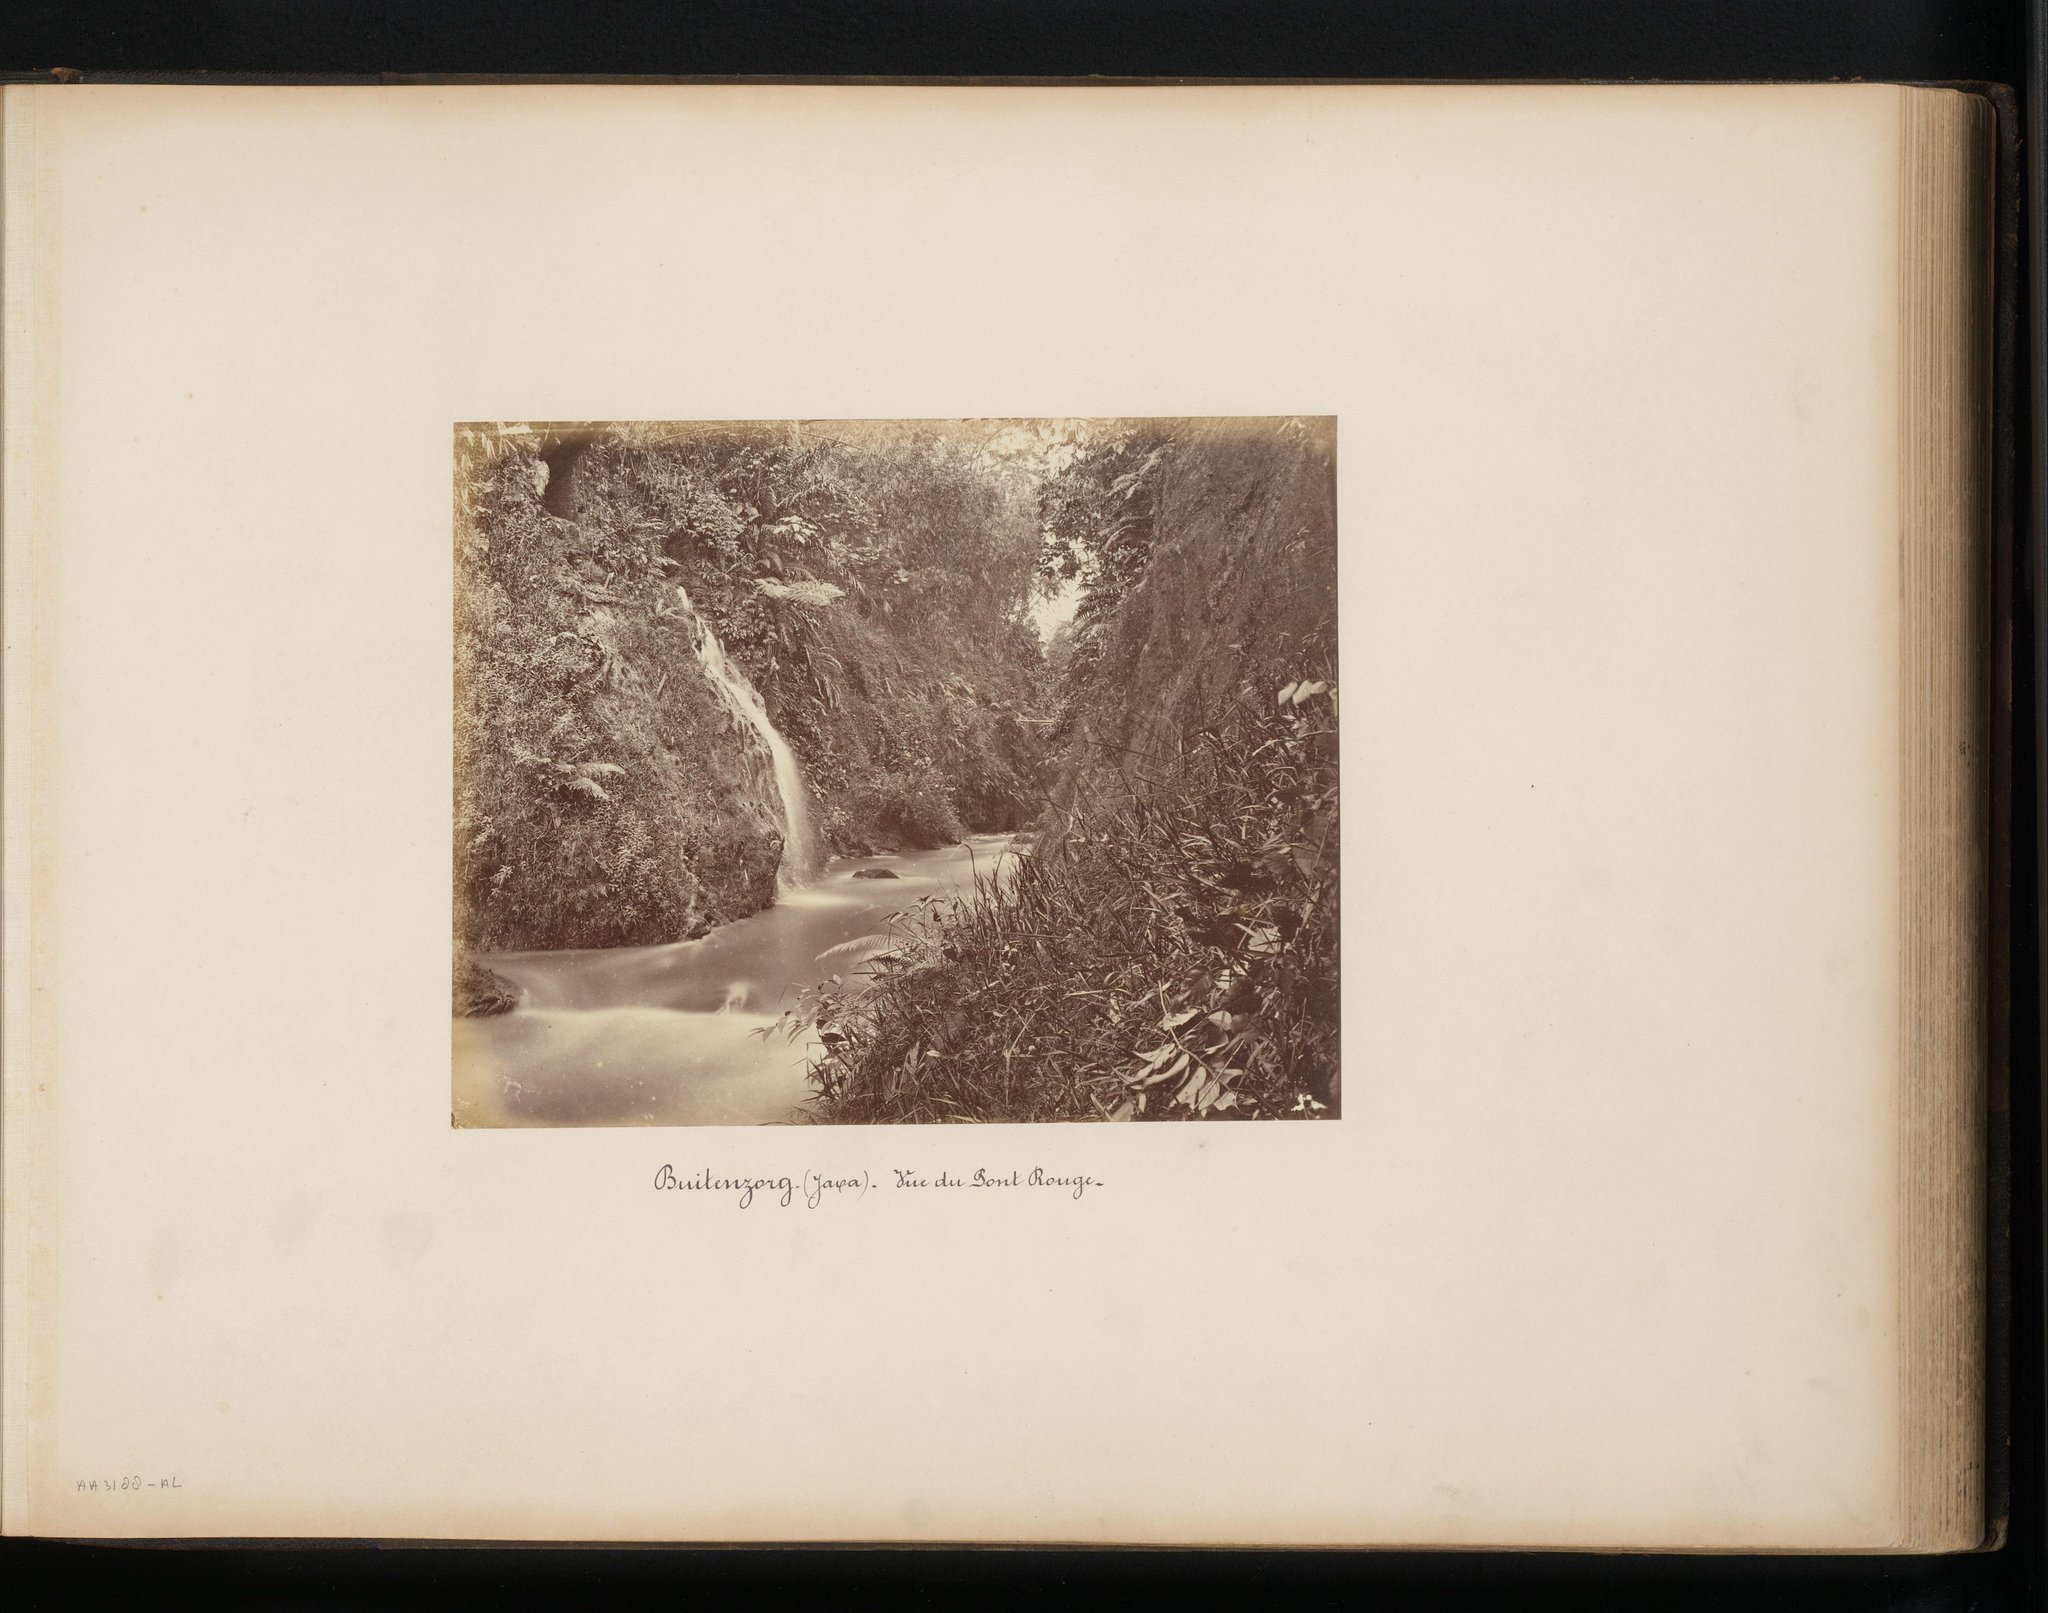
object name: photograph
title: Waterval bij een rivier te Buitenzorg, gezien vanaf de Roode Brug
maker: Anonymous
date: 1880-1883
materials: photographic support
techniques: albumen print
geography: buitenzorg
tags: waterfall, river (+ landscape with figures, staffage)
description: Onderdeel van Reisalbum met opnames van bezienswaardigheden in Egypte, Nederlands-Indië, Singapore en Ceylon.